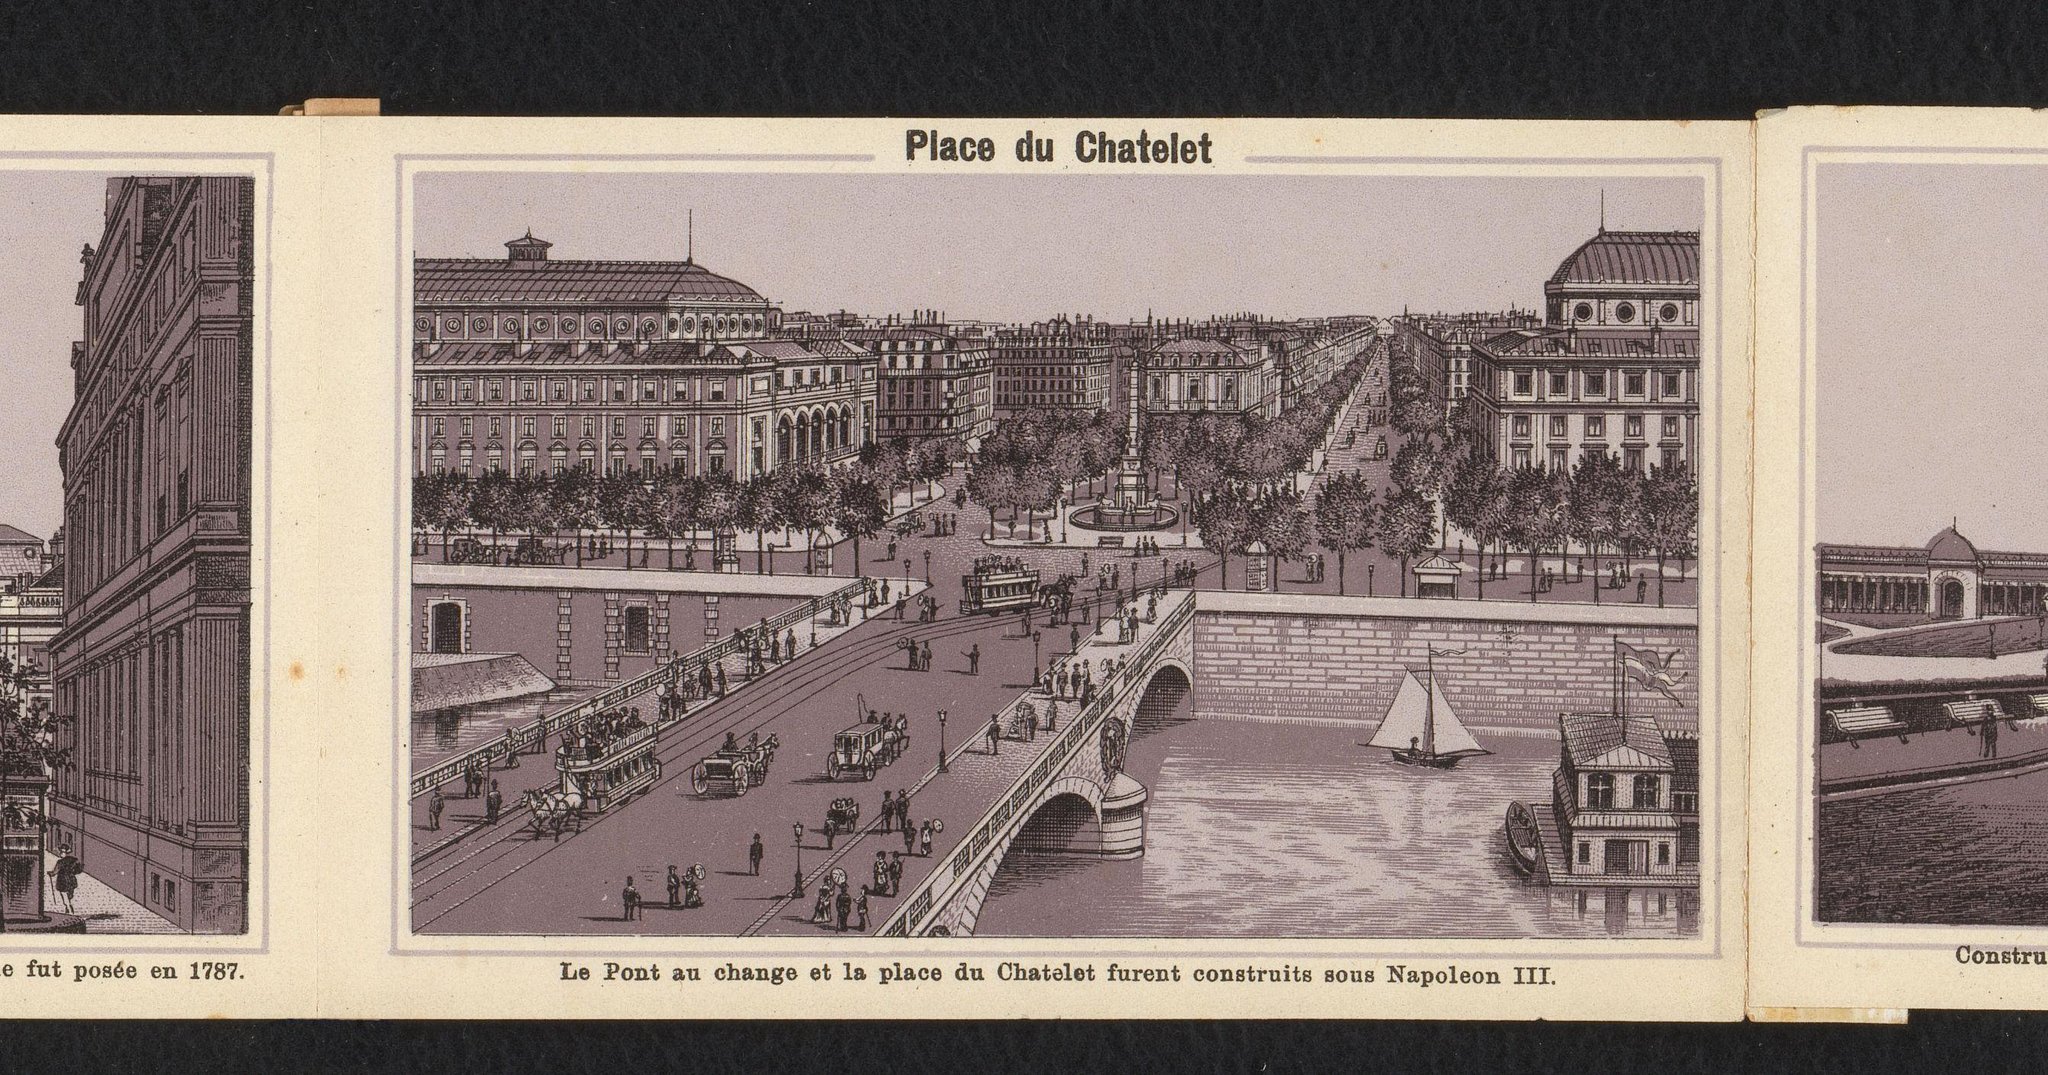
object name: print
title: Place du Chatelet. Le Pont au Change et la Place du Chatelet furent construits sous Napoleon III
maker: Anonymous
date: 1890-1910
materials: cardboard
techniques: lithograph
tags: court building, river, city-view, and landscape with man-made constructions (+ city(-scape) with figures, staffage)